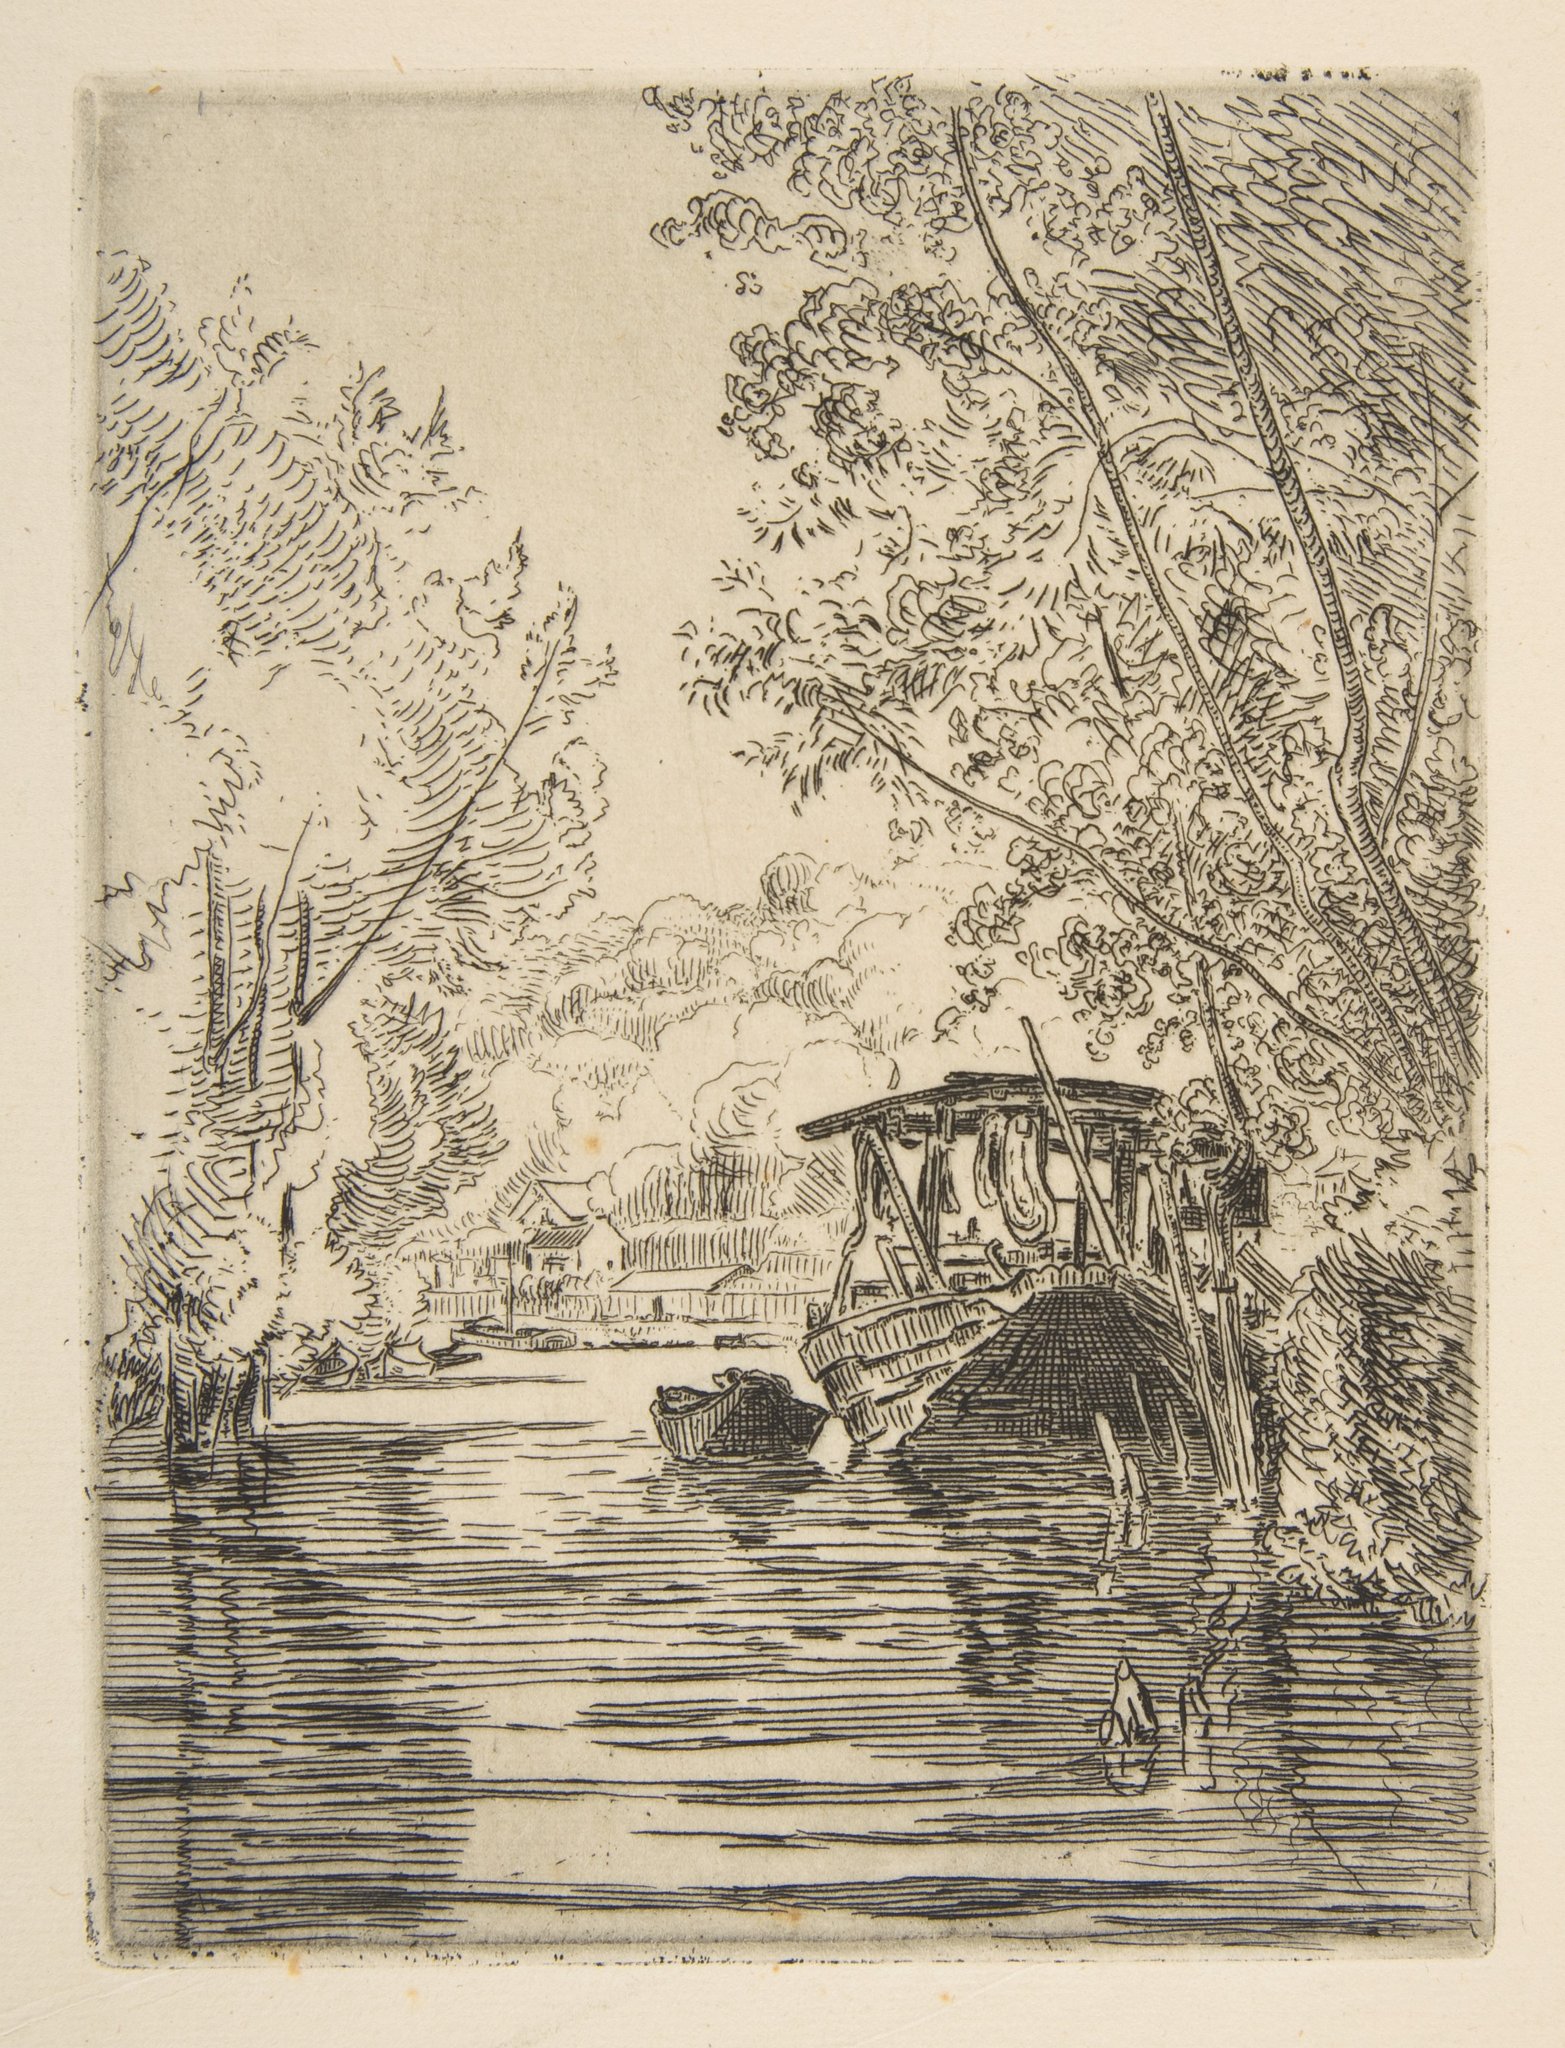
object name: print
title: The Dyer's Boat (Bas-Meudon)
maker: félix bracquemond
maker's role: artist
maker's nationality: french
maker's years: 1833-1914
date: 1868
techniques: etching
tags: rivers,boats